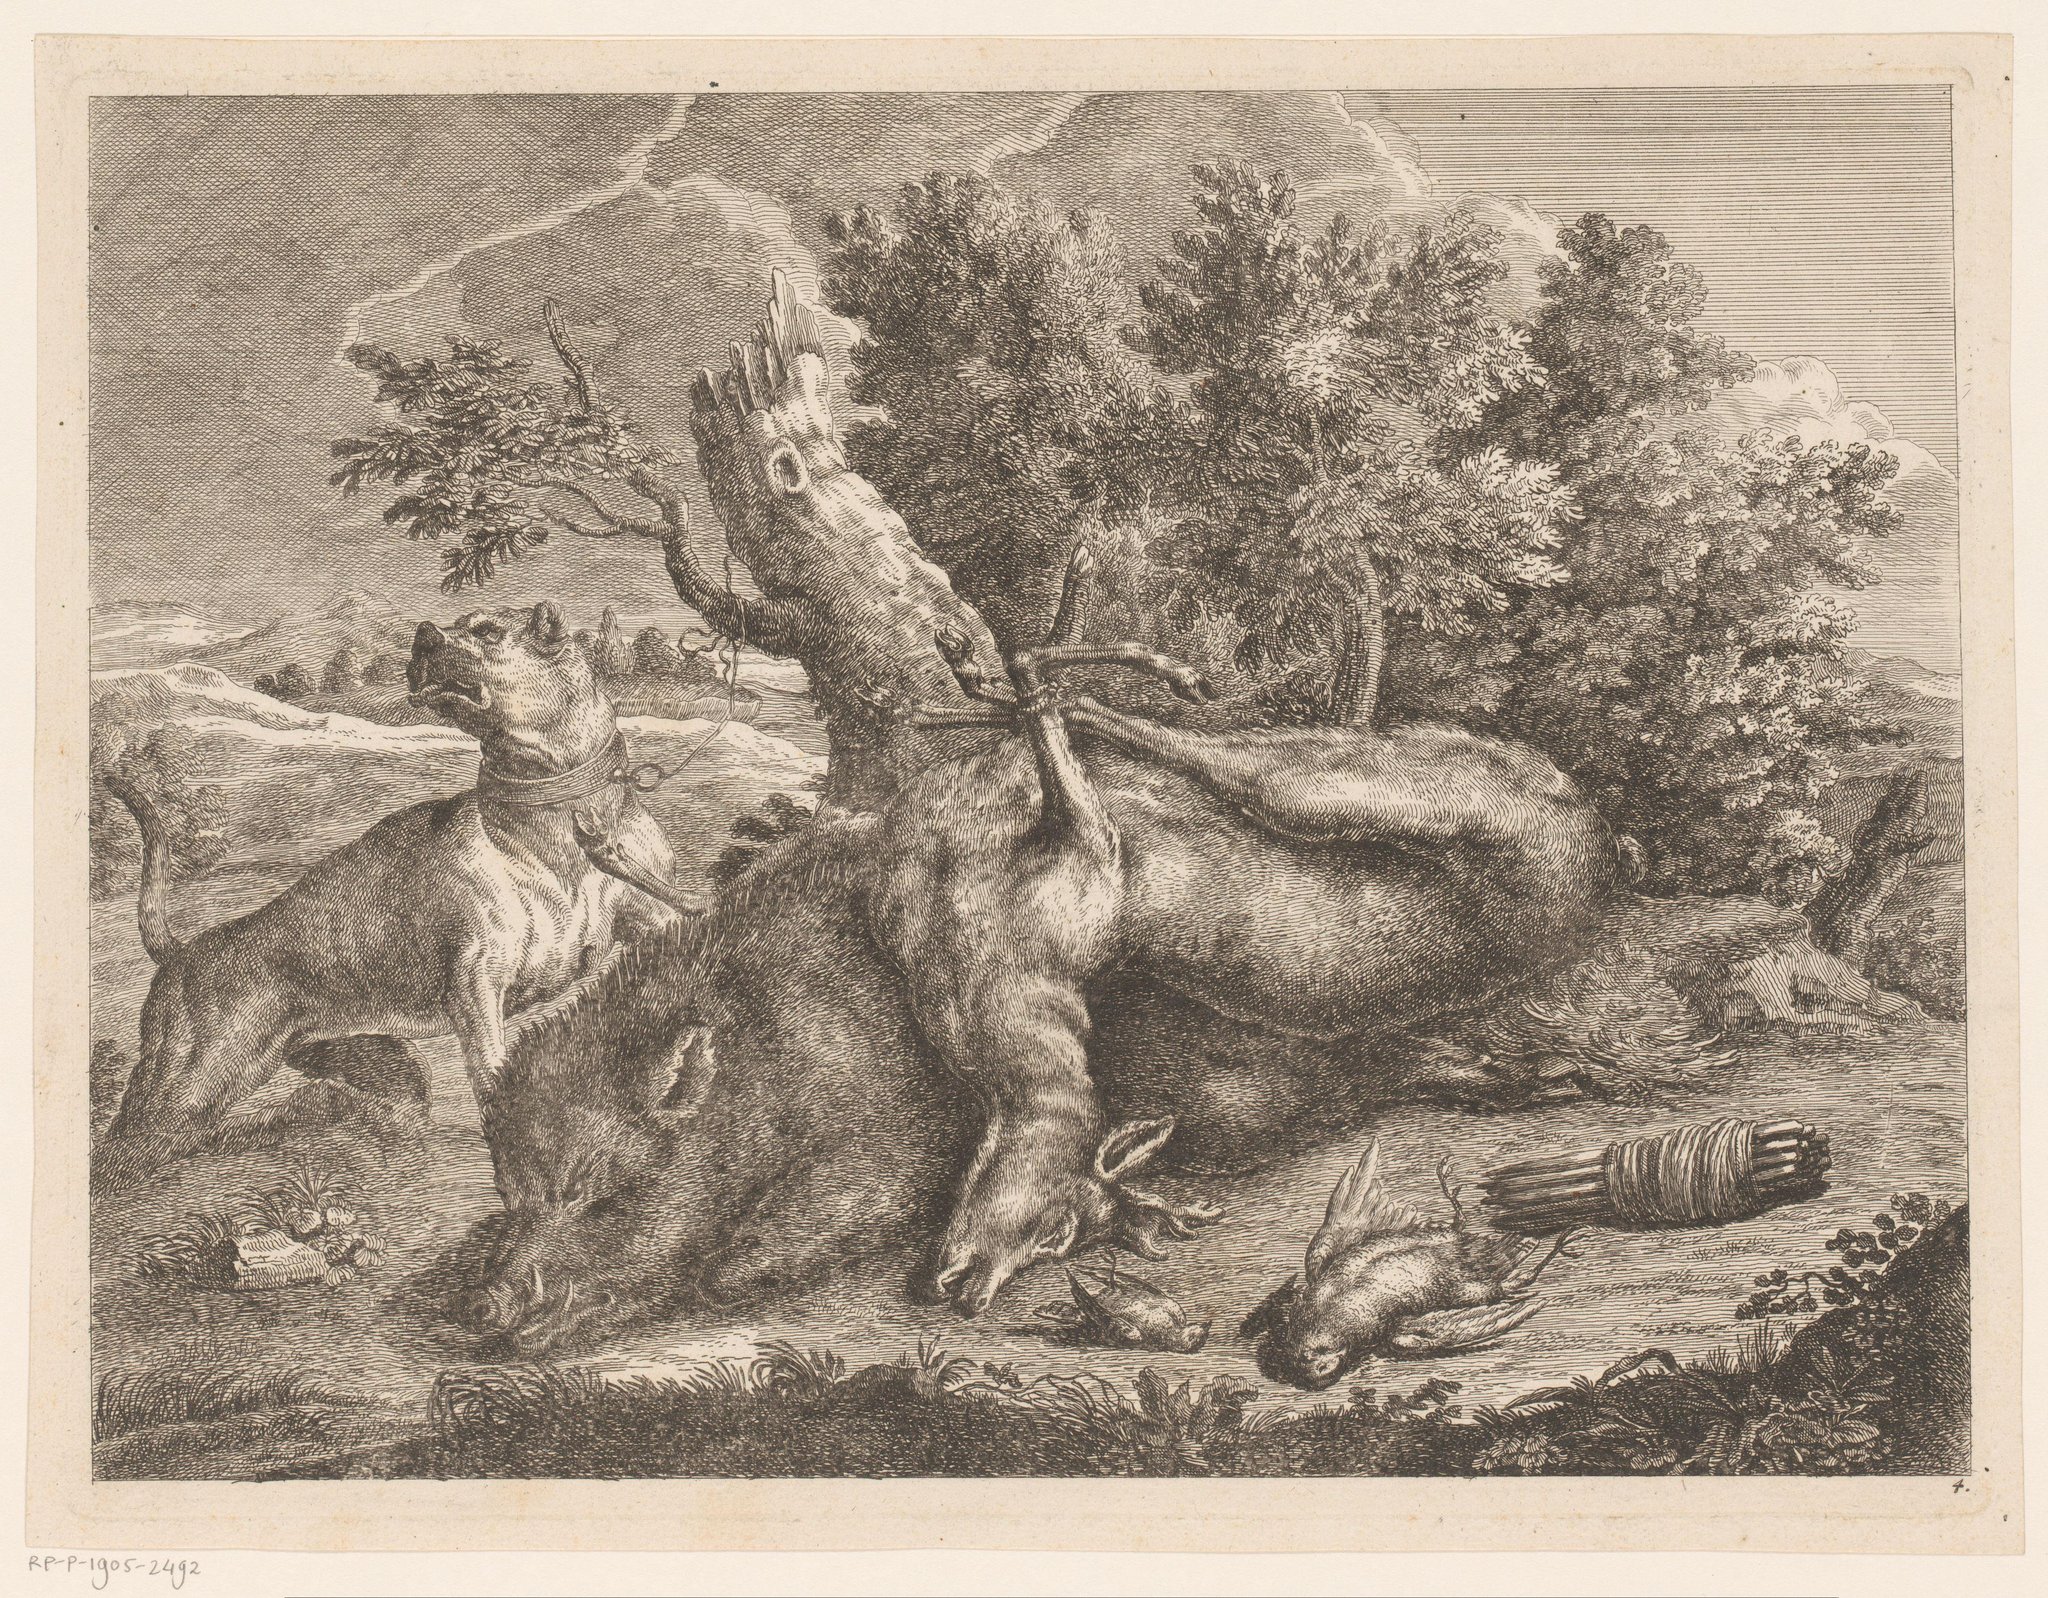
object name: print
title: Jachthond en jachtbuit met zwijn, hert en vogels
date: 1725-1790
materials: paper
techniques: etching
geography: nuremberg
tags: hoofed animals: deer, hunting dogs, hoofed animals: boar, spoils of the hunt, game, venison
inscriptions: collector's mark: Lugt 2228